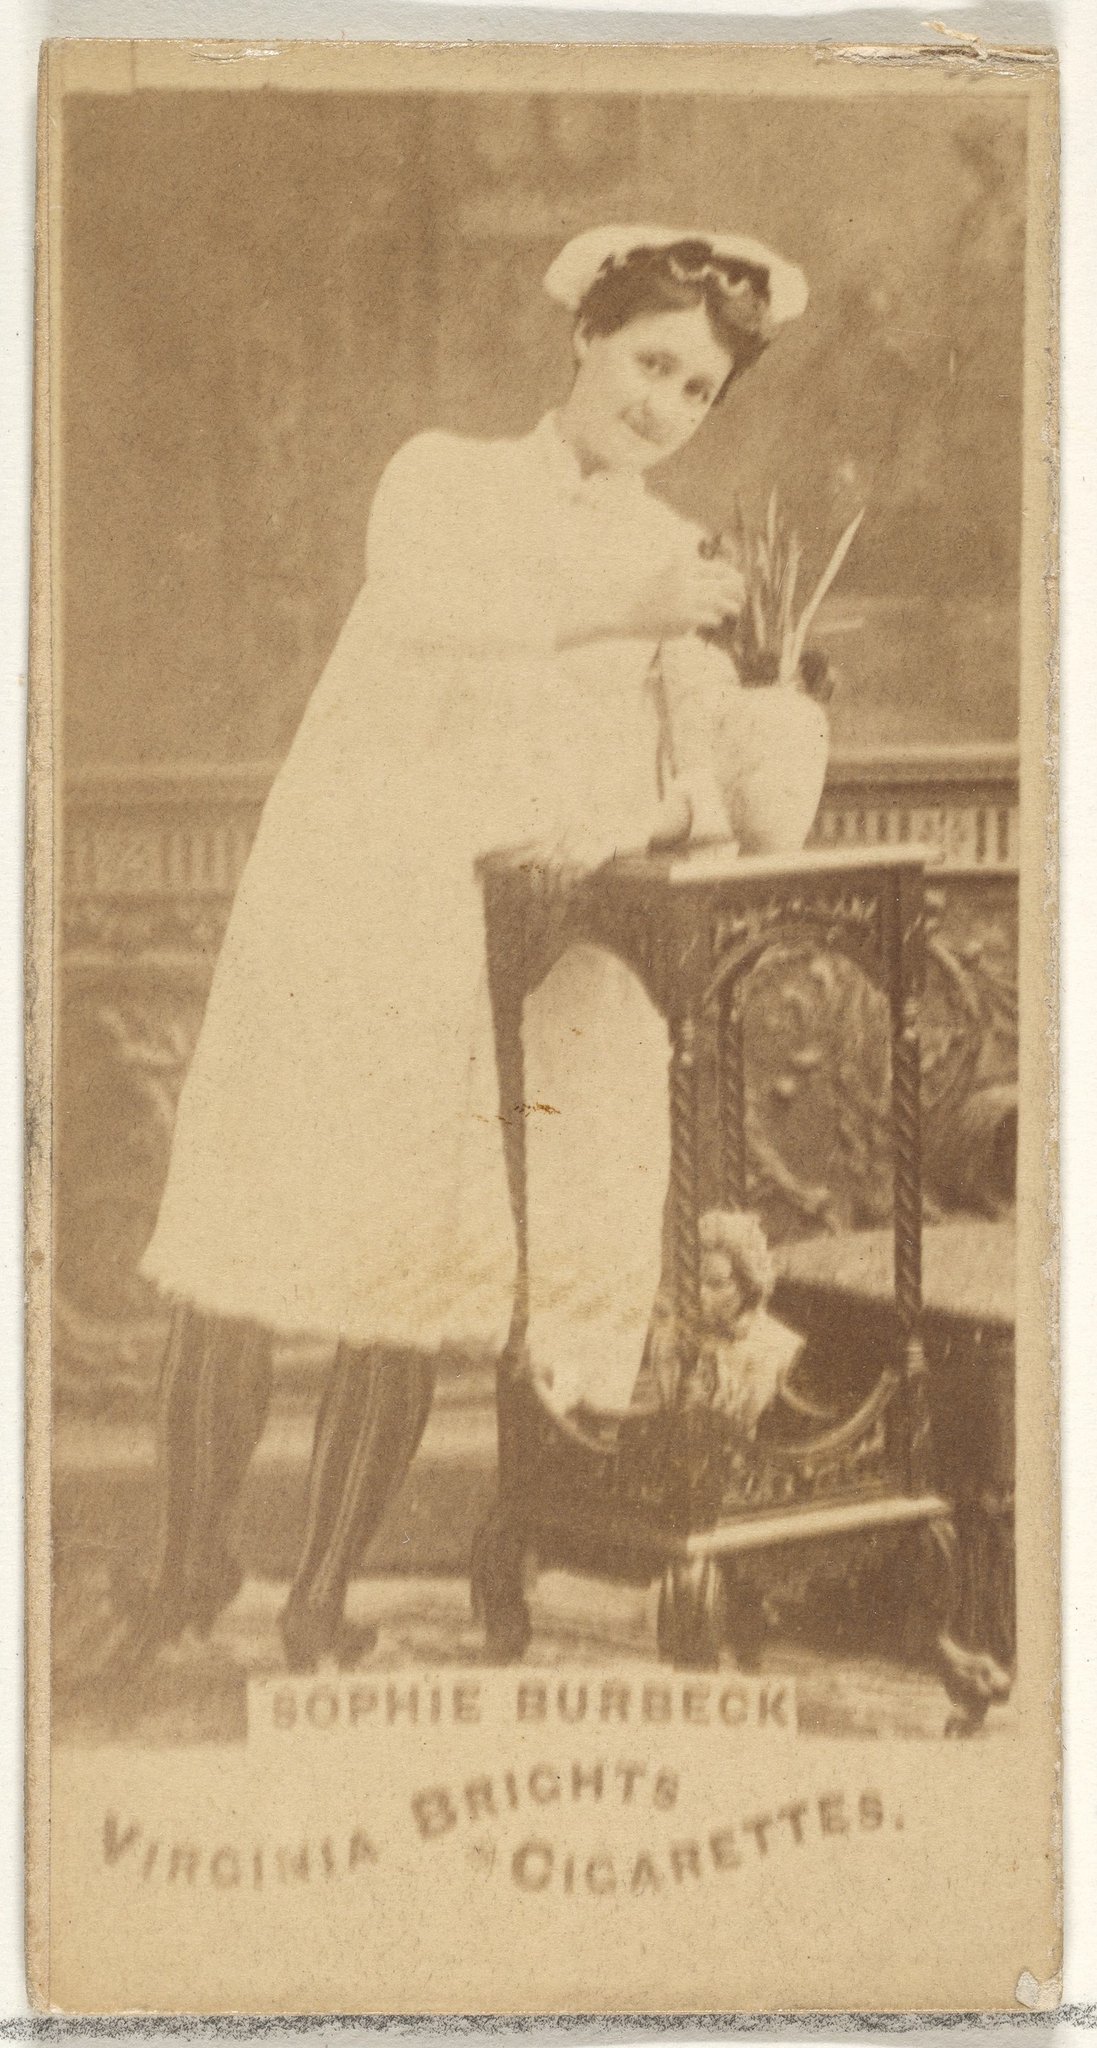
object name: photograph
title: Sophie Burbeck, from the Actors and Actresses series (N45, Type 1) for Virginia Brights Cigarettes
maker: allen & ginter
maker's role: publisher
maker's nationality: american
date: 1888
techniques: albumen silver print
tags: portraits,women,actresses